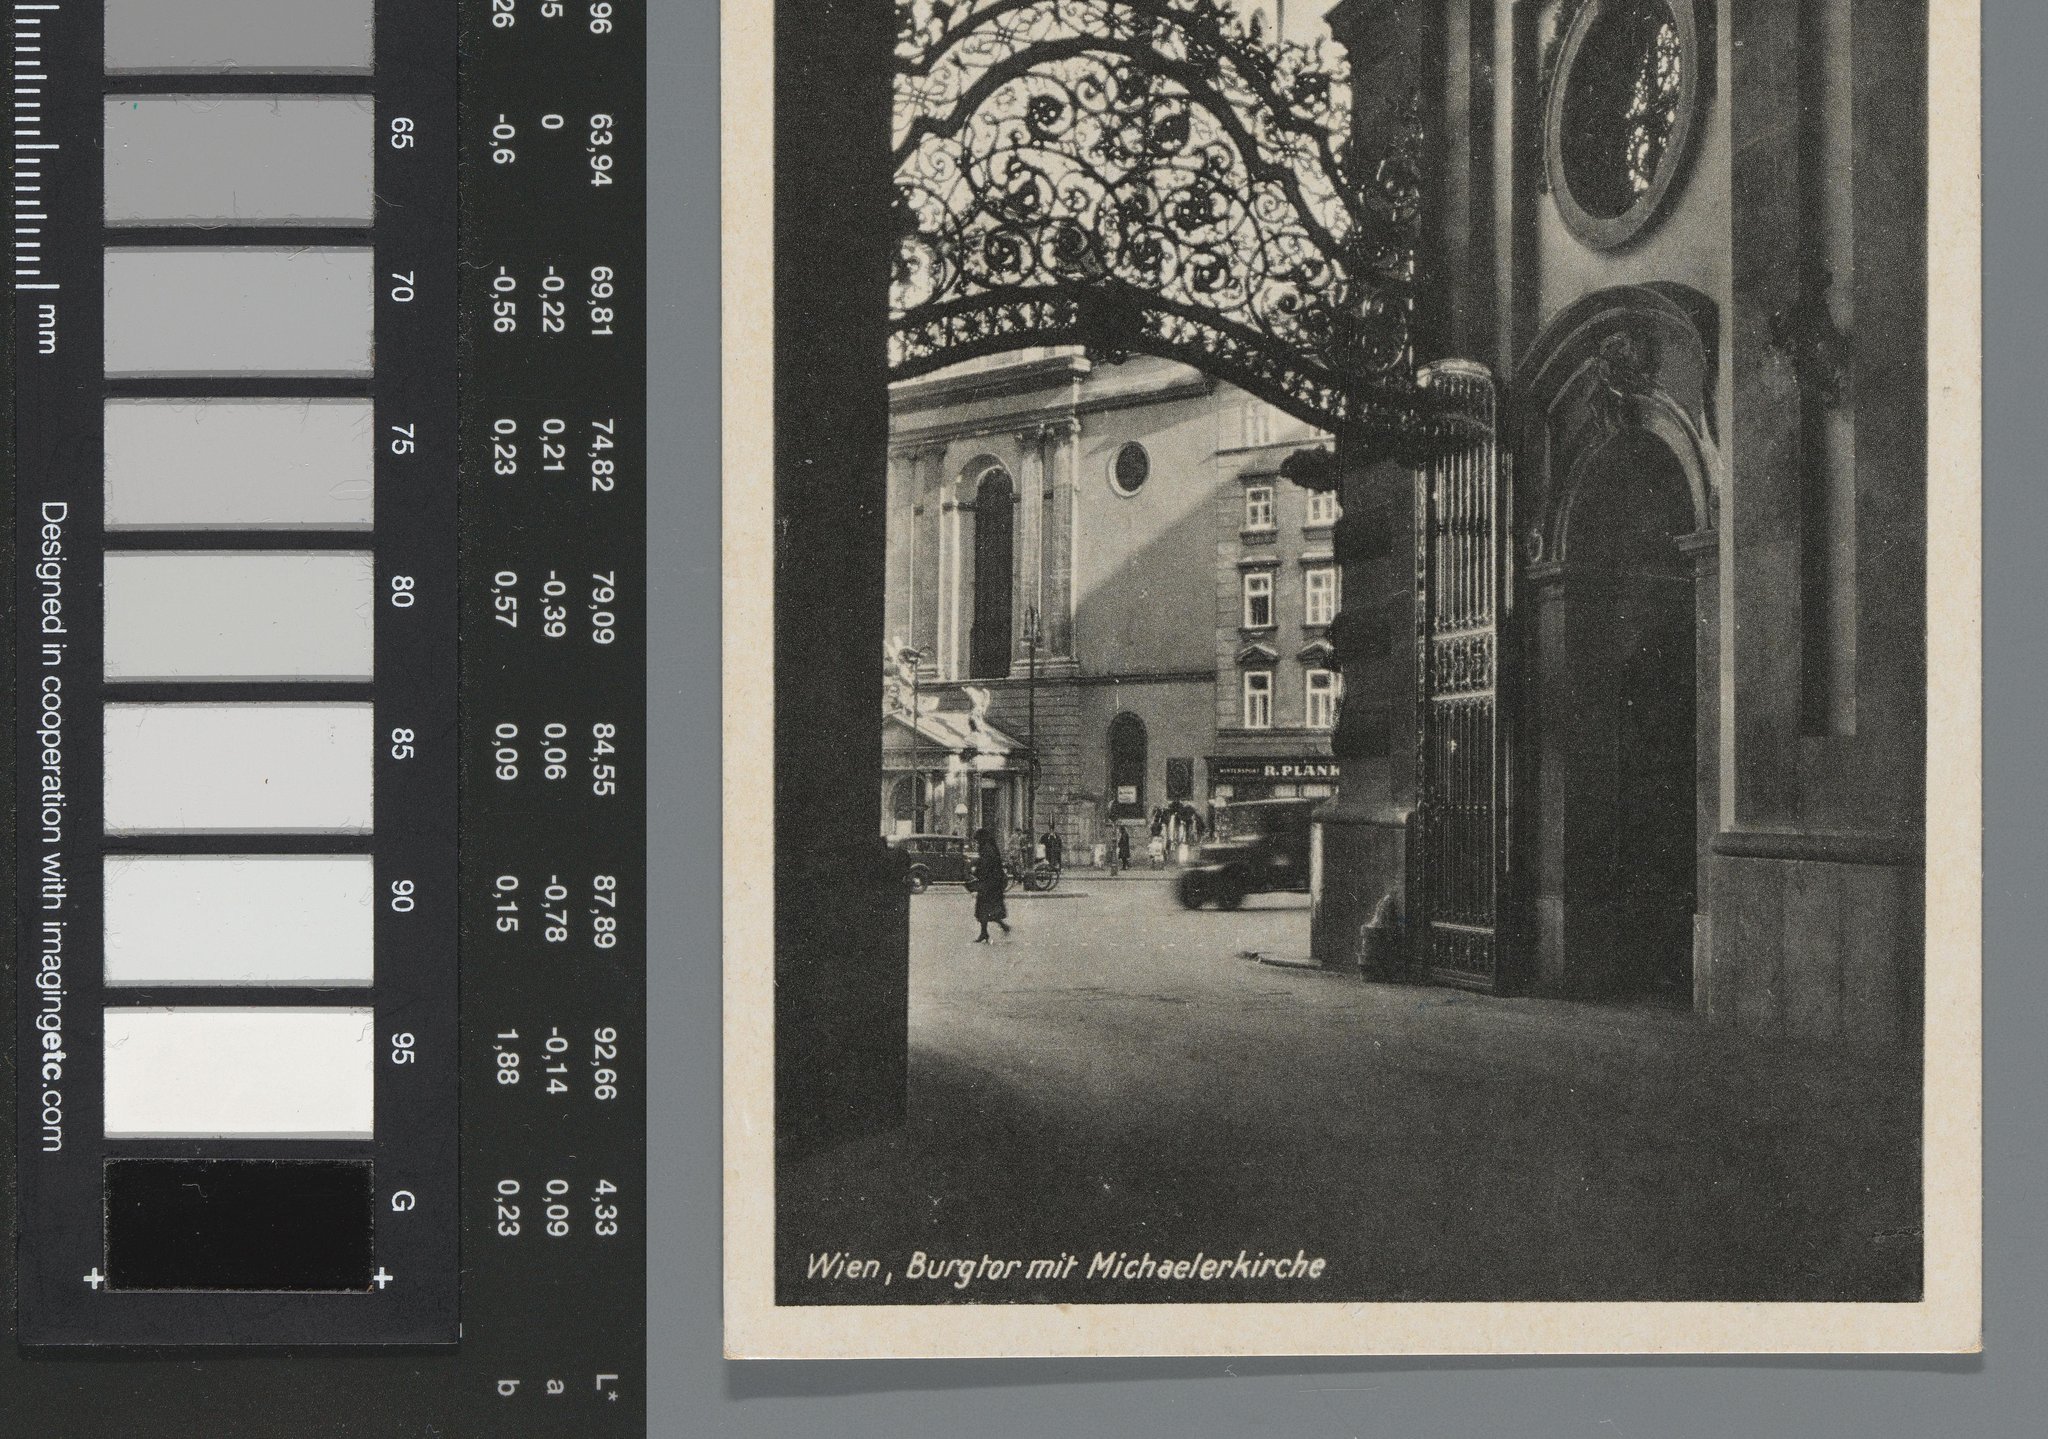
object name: postcard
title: Wien, Burgtor mit Michaelerkirche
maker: Anonymous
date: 1920-1950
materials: photographic support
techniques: photograph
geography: vienna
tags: vienna